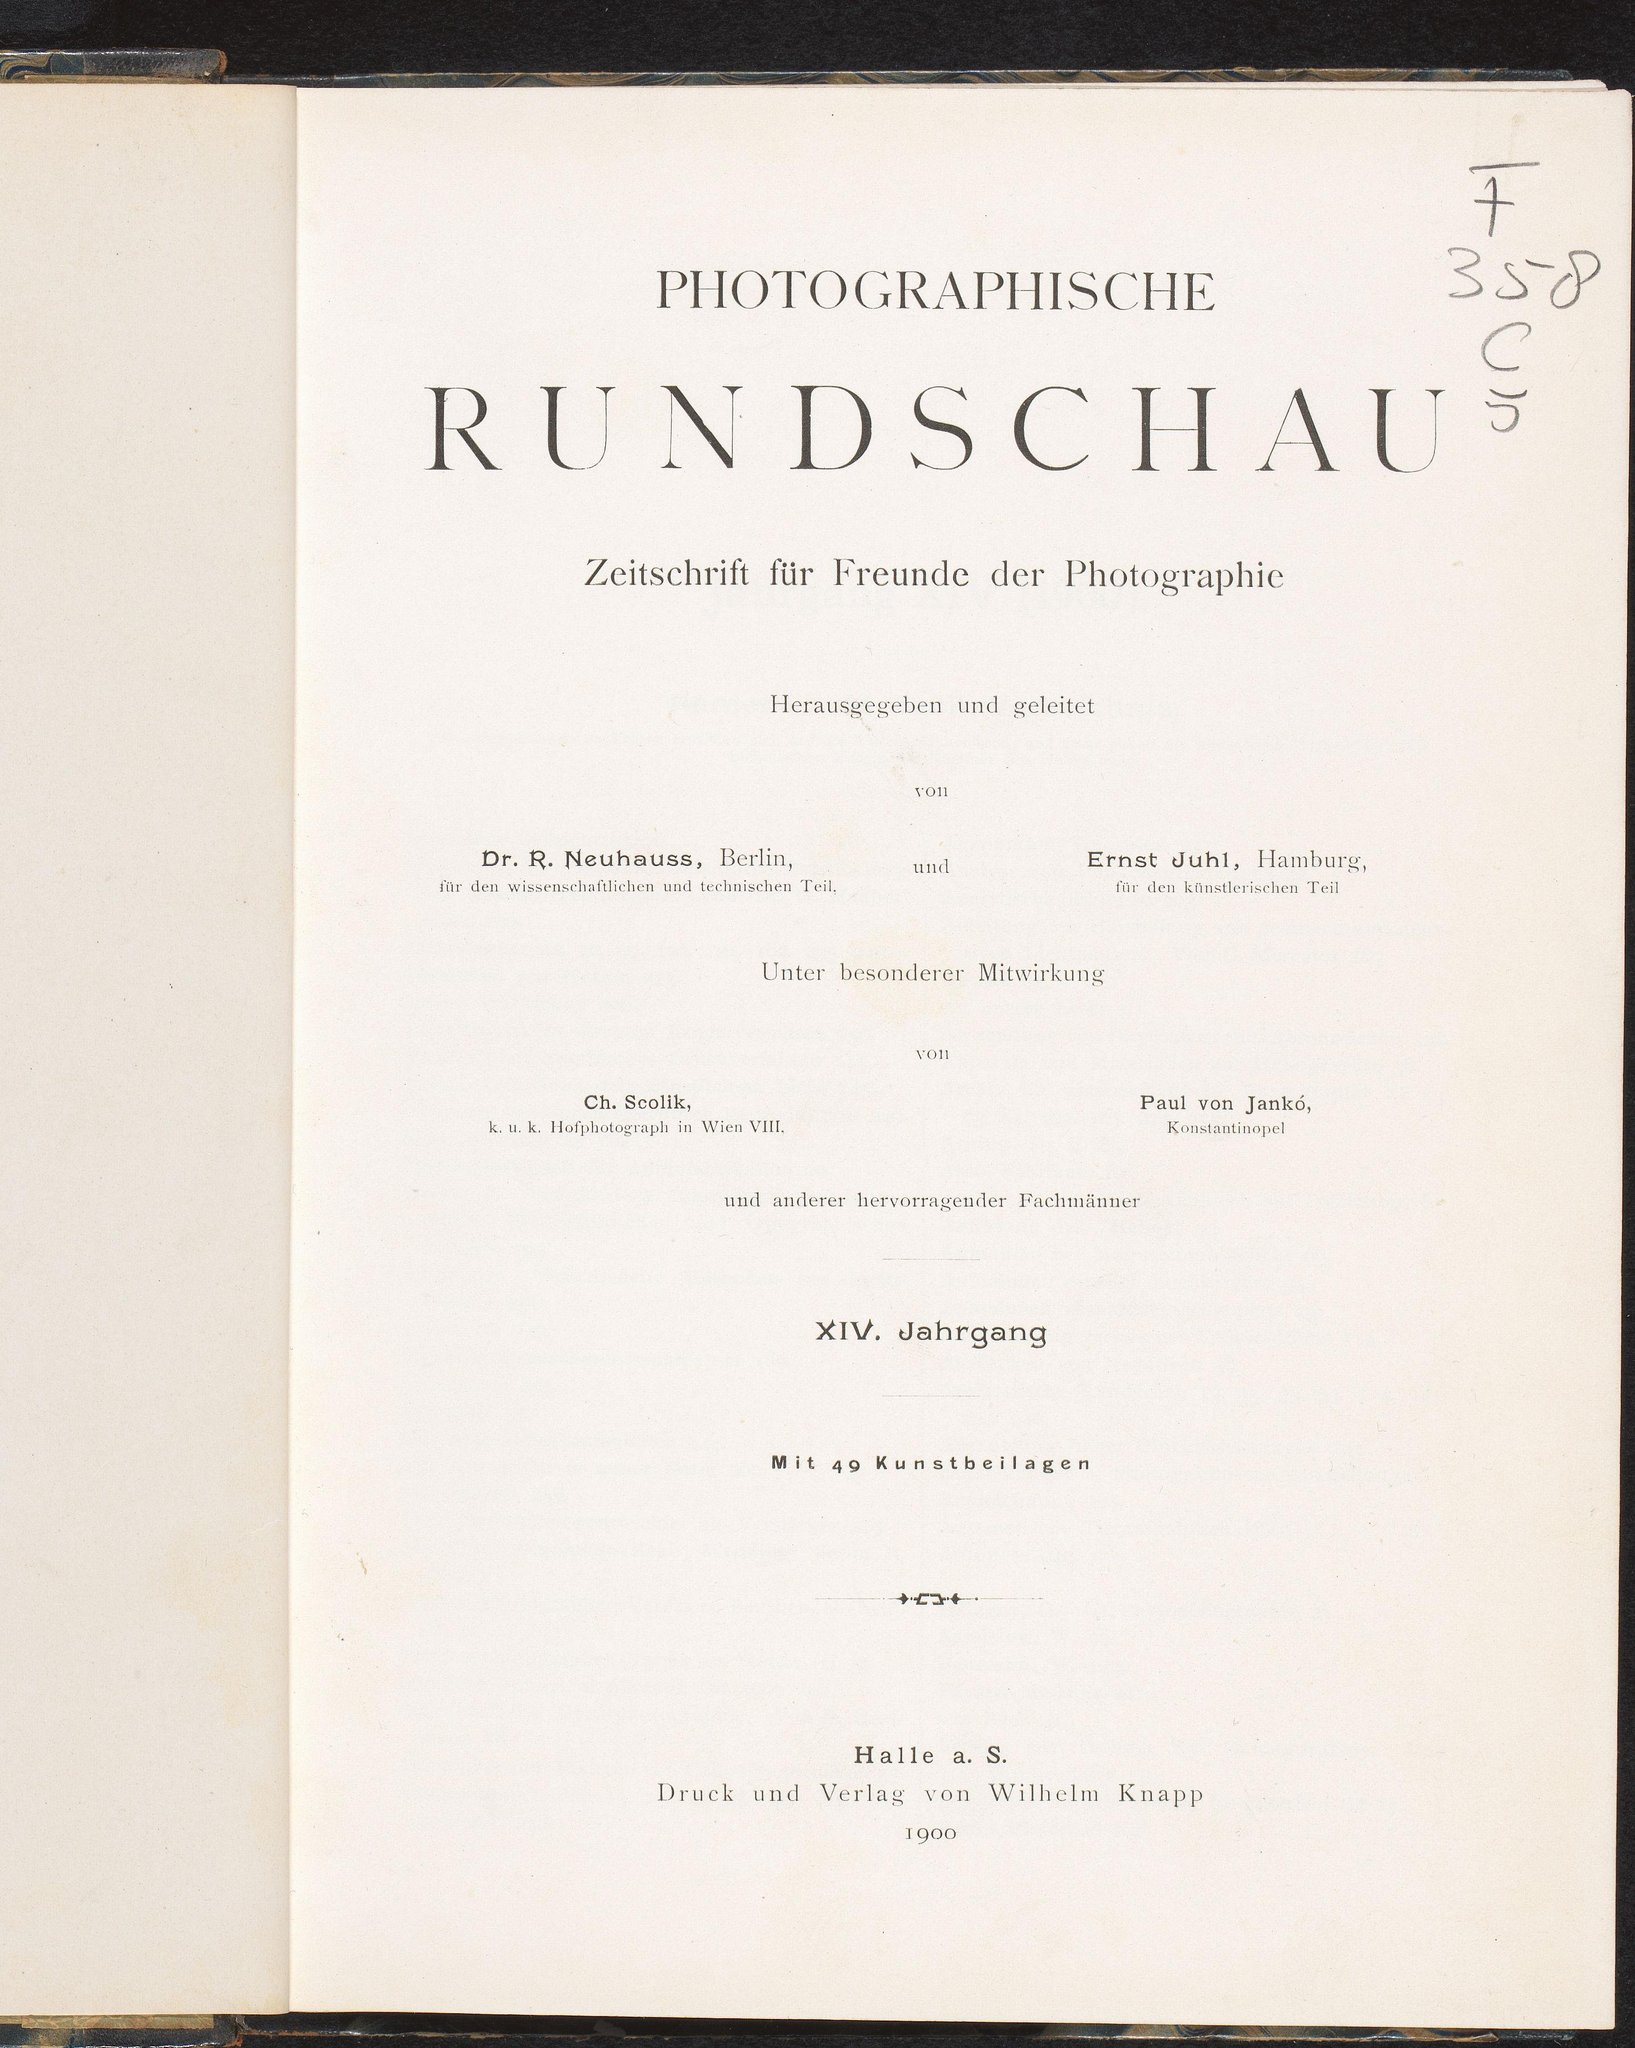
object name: magazine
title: Photographische Rundschau : Zeitschrift für Freunde der Photographie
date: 1895-1900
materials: cardboard, linen, paper, photographic support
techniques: photoaquatint, marbled paper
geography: halle an der saale